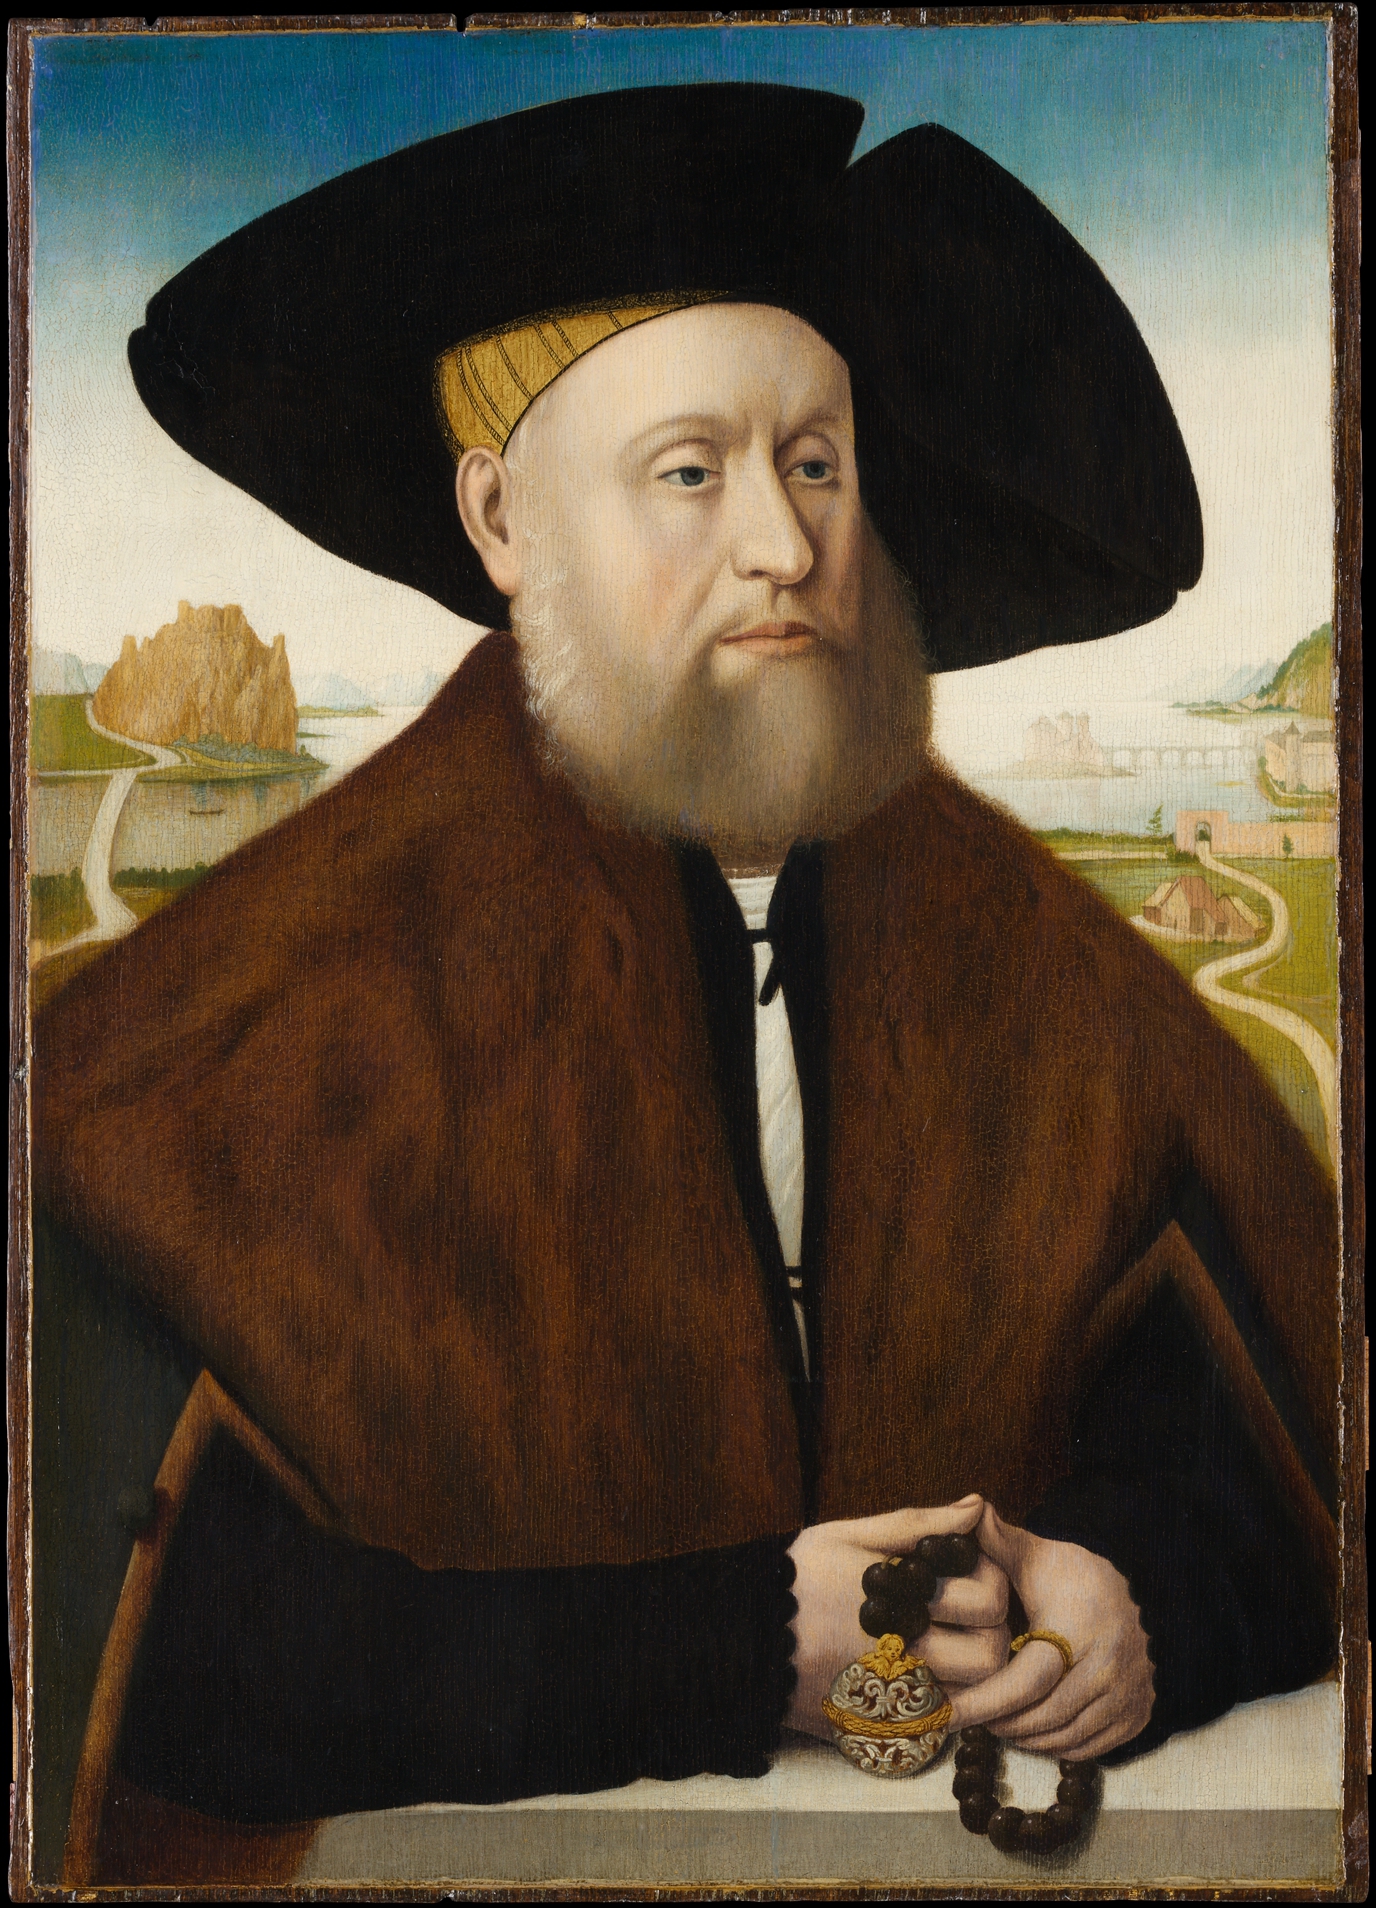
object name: painting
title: Heinrich(?) vom Rhein zum Mohren (1477–1536)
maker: conrad faber von creuznach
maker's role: artist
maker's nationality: german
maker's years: 1524-1553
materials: gold, wood, oil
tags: men,portraits